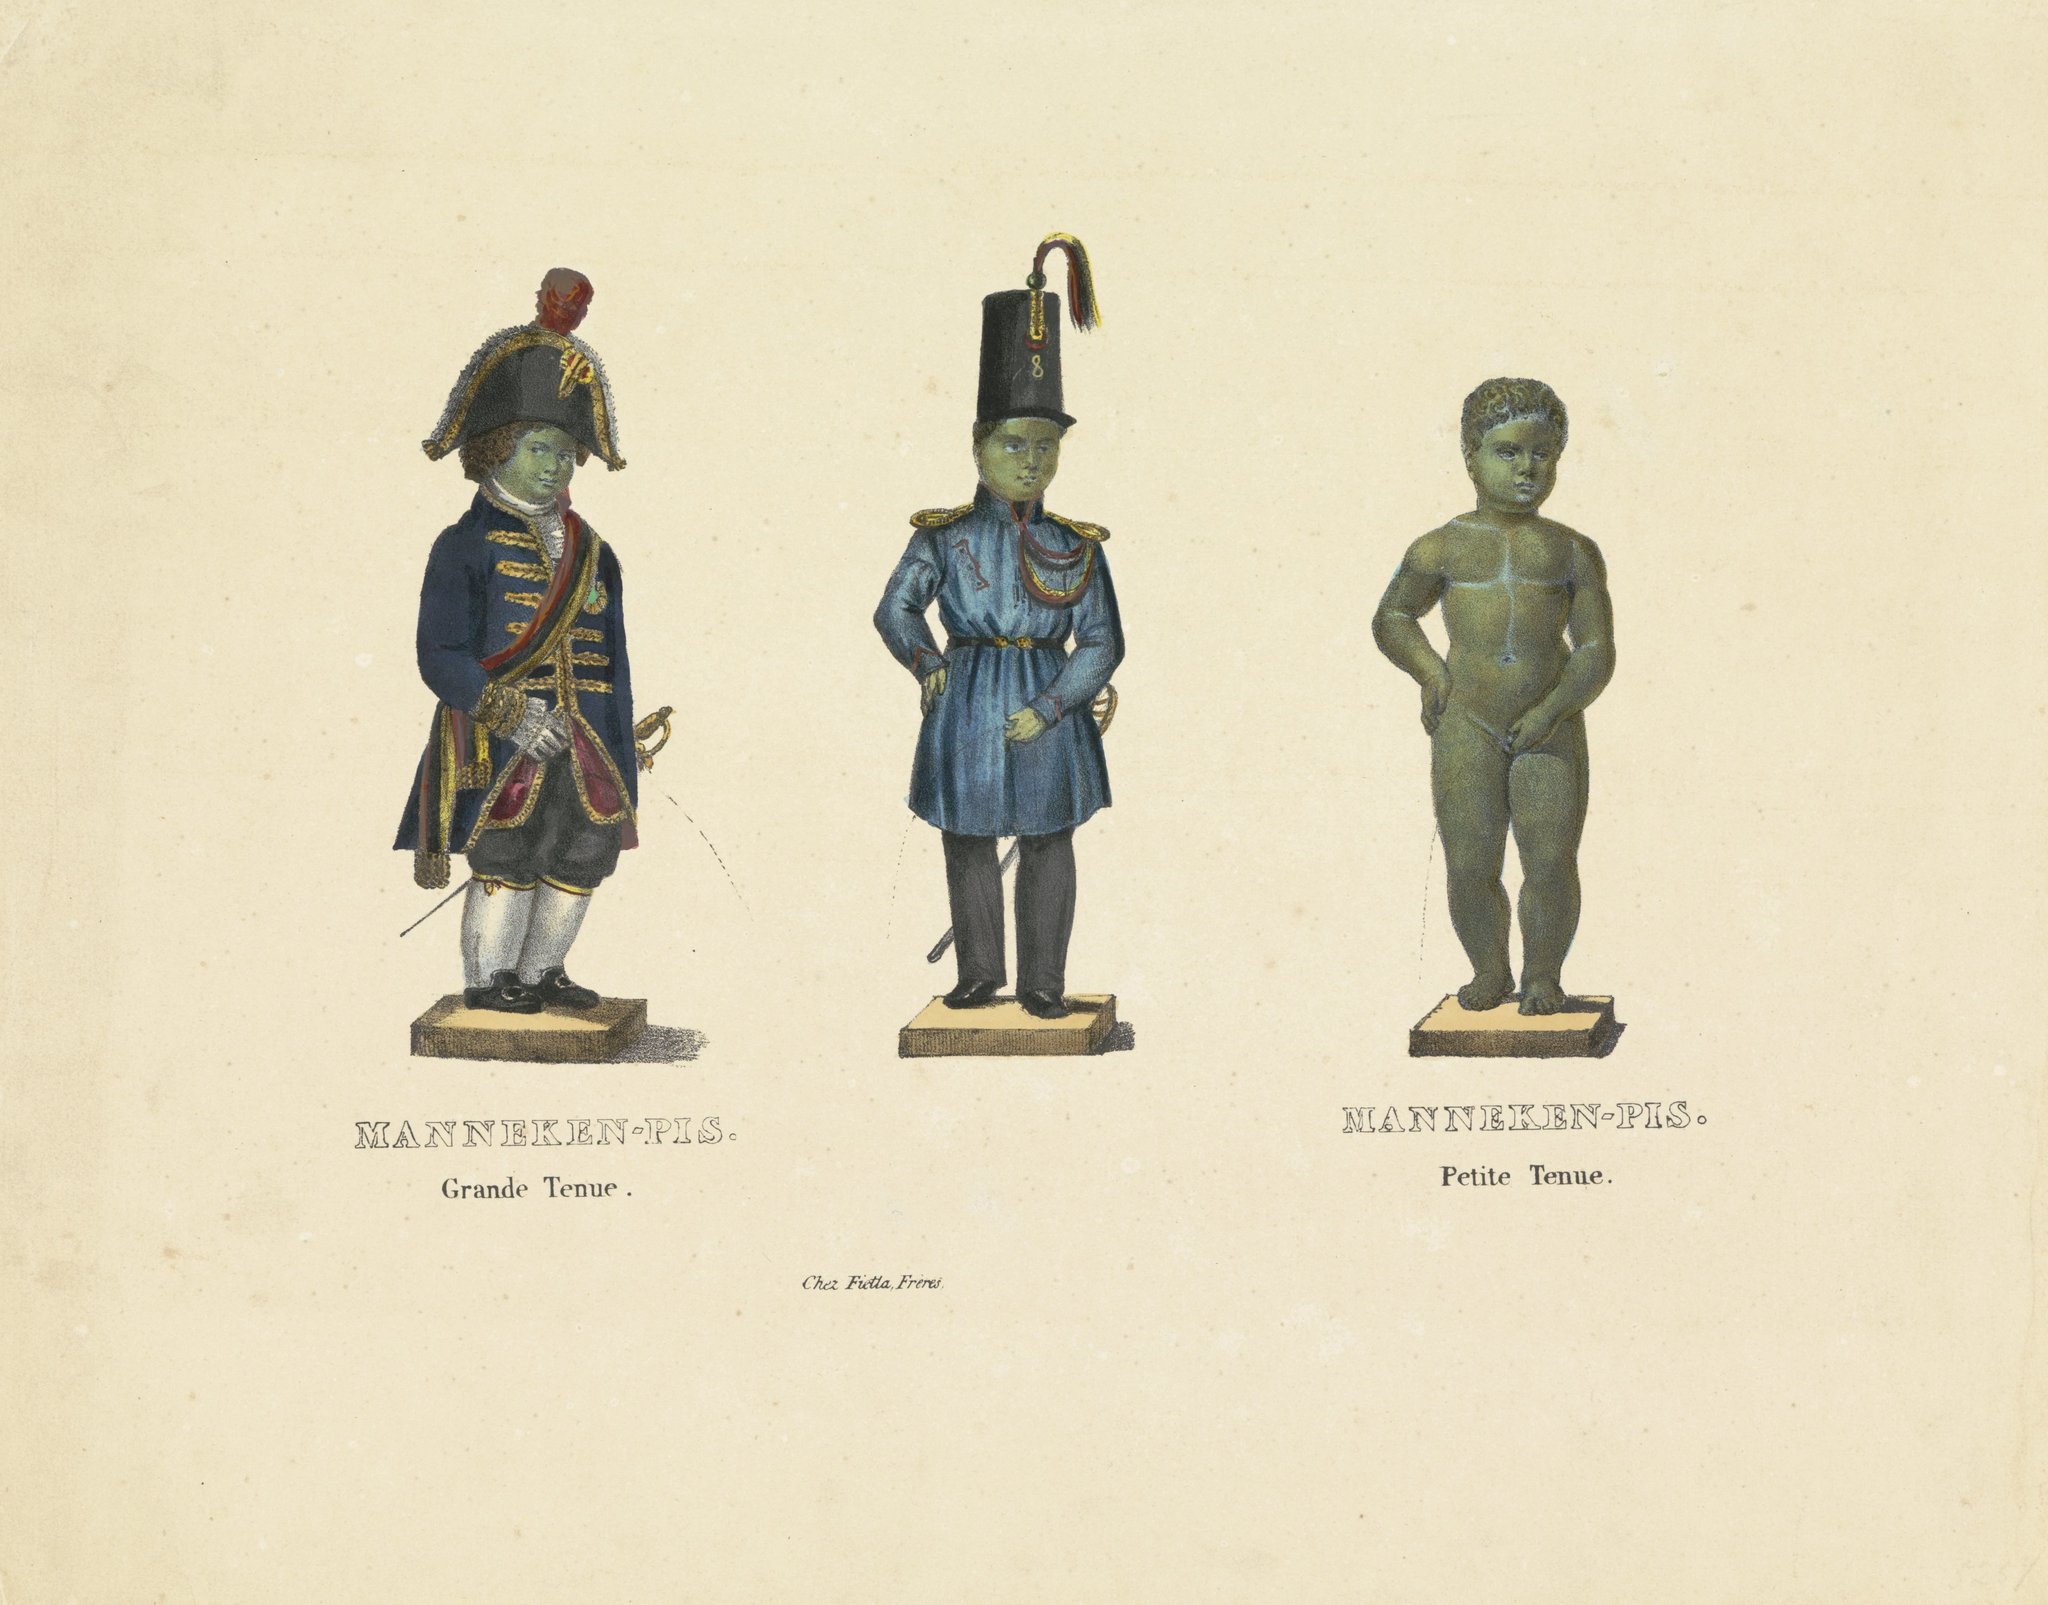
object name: print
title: Manneken-Pis. Grande Tenue. Manneken-Pis. Petite Tenue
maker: Anonymous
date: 1810-1830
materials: paper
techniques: hand coloring, lithograph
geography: belgium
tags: piece of sculpture, reproduction of a piece of sculpture (+ parody, caricature ~ work of art), brussels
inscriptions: collector's mark: Lugt Lugt 2228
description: Drie voorstellingen van het standbeeldje van Manneken Pis te Brussel, zonder kleren en aangekleed in twee militaire uniformen. Hier opgenomen vanwege de diefstal van het beeldje in de nacht van 4 op 5 oktober 1817.